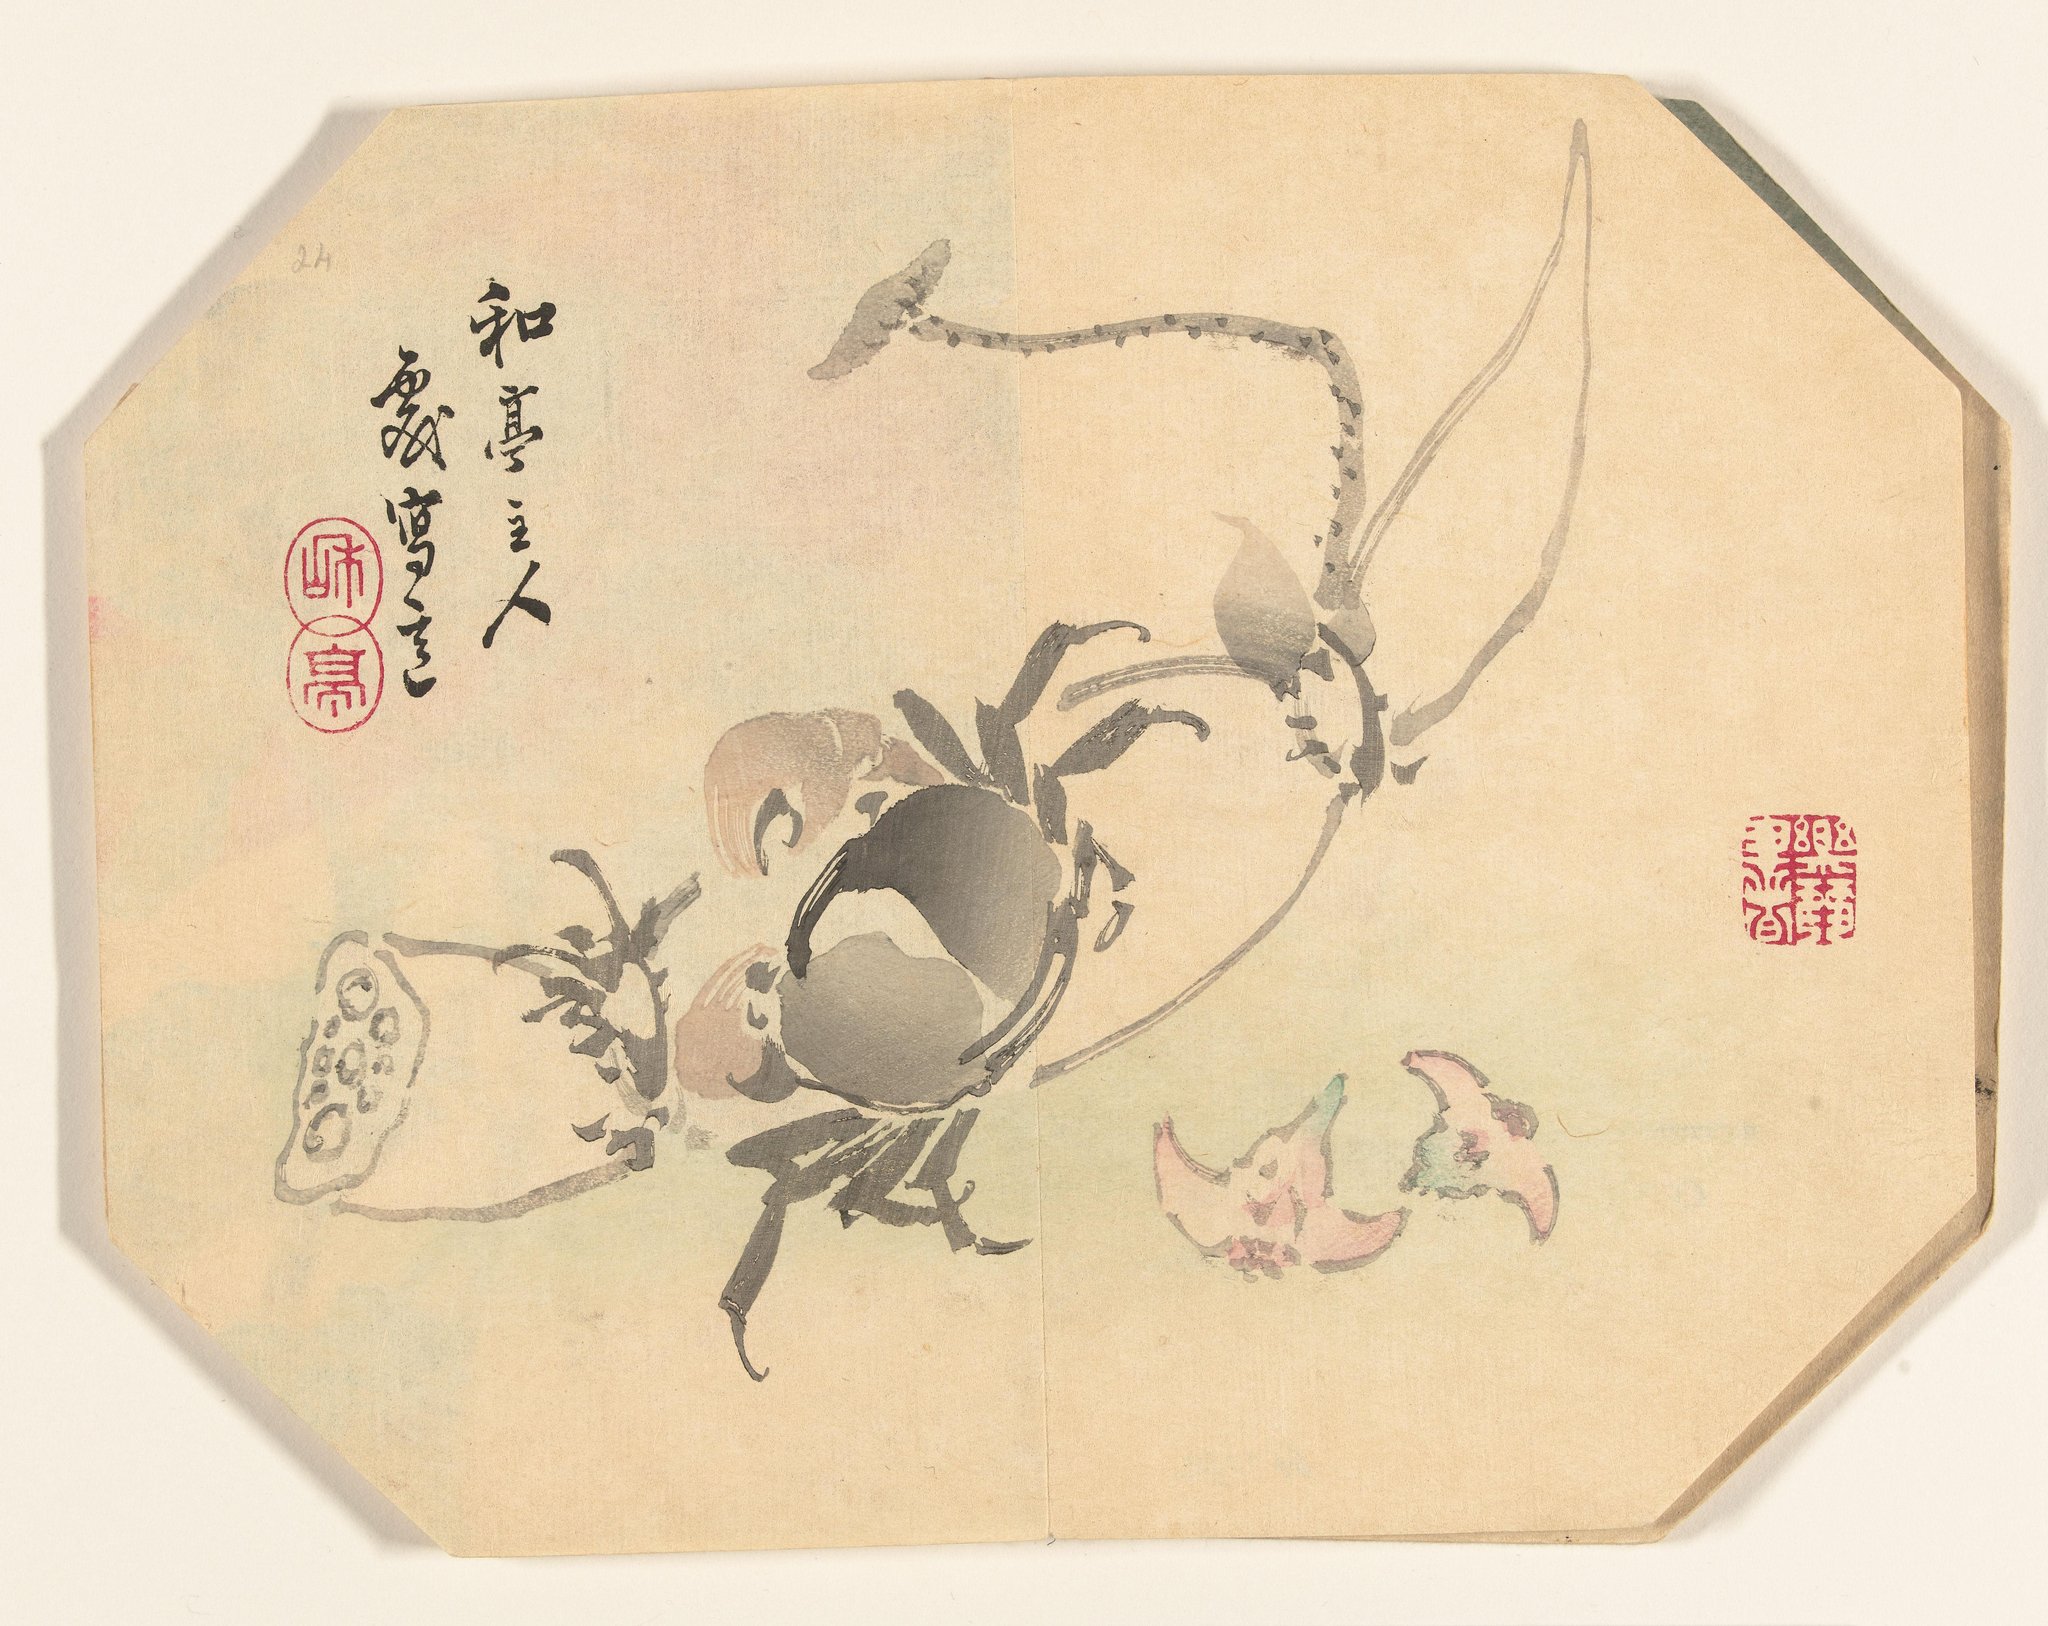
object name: print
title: Krab en lotusplant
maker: taki katei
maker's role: print maker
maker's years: 1830-1901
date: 1880-1890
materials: paper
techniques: woodcut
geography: japan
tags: plants; vegetation, crustaceans: crab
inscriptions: collector's mark: Lugt 2228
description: Octogonale prent uit album met 39 prenten.